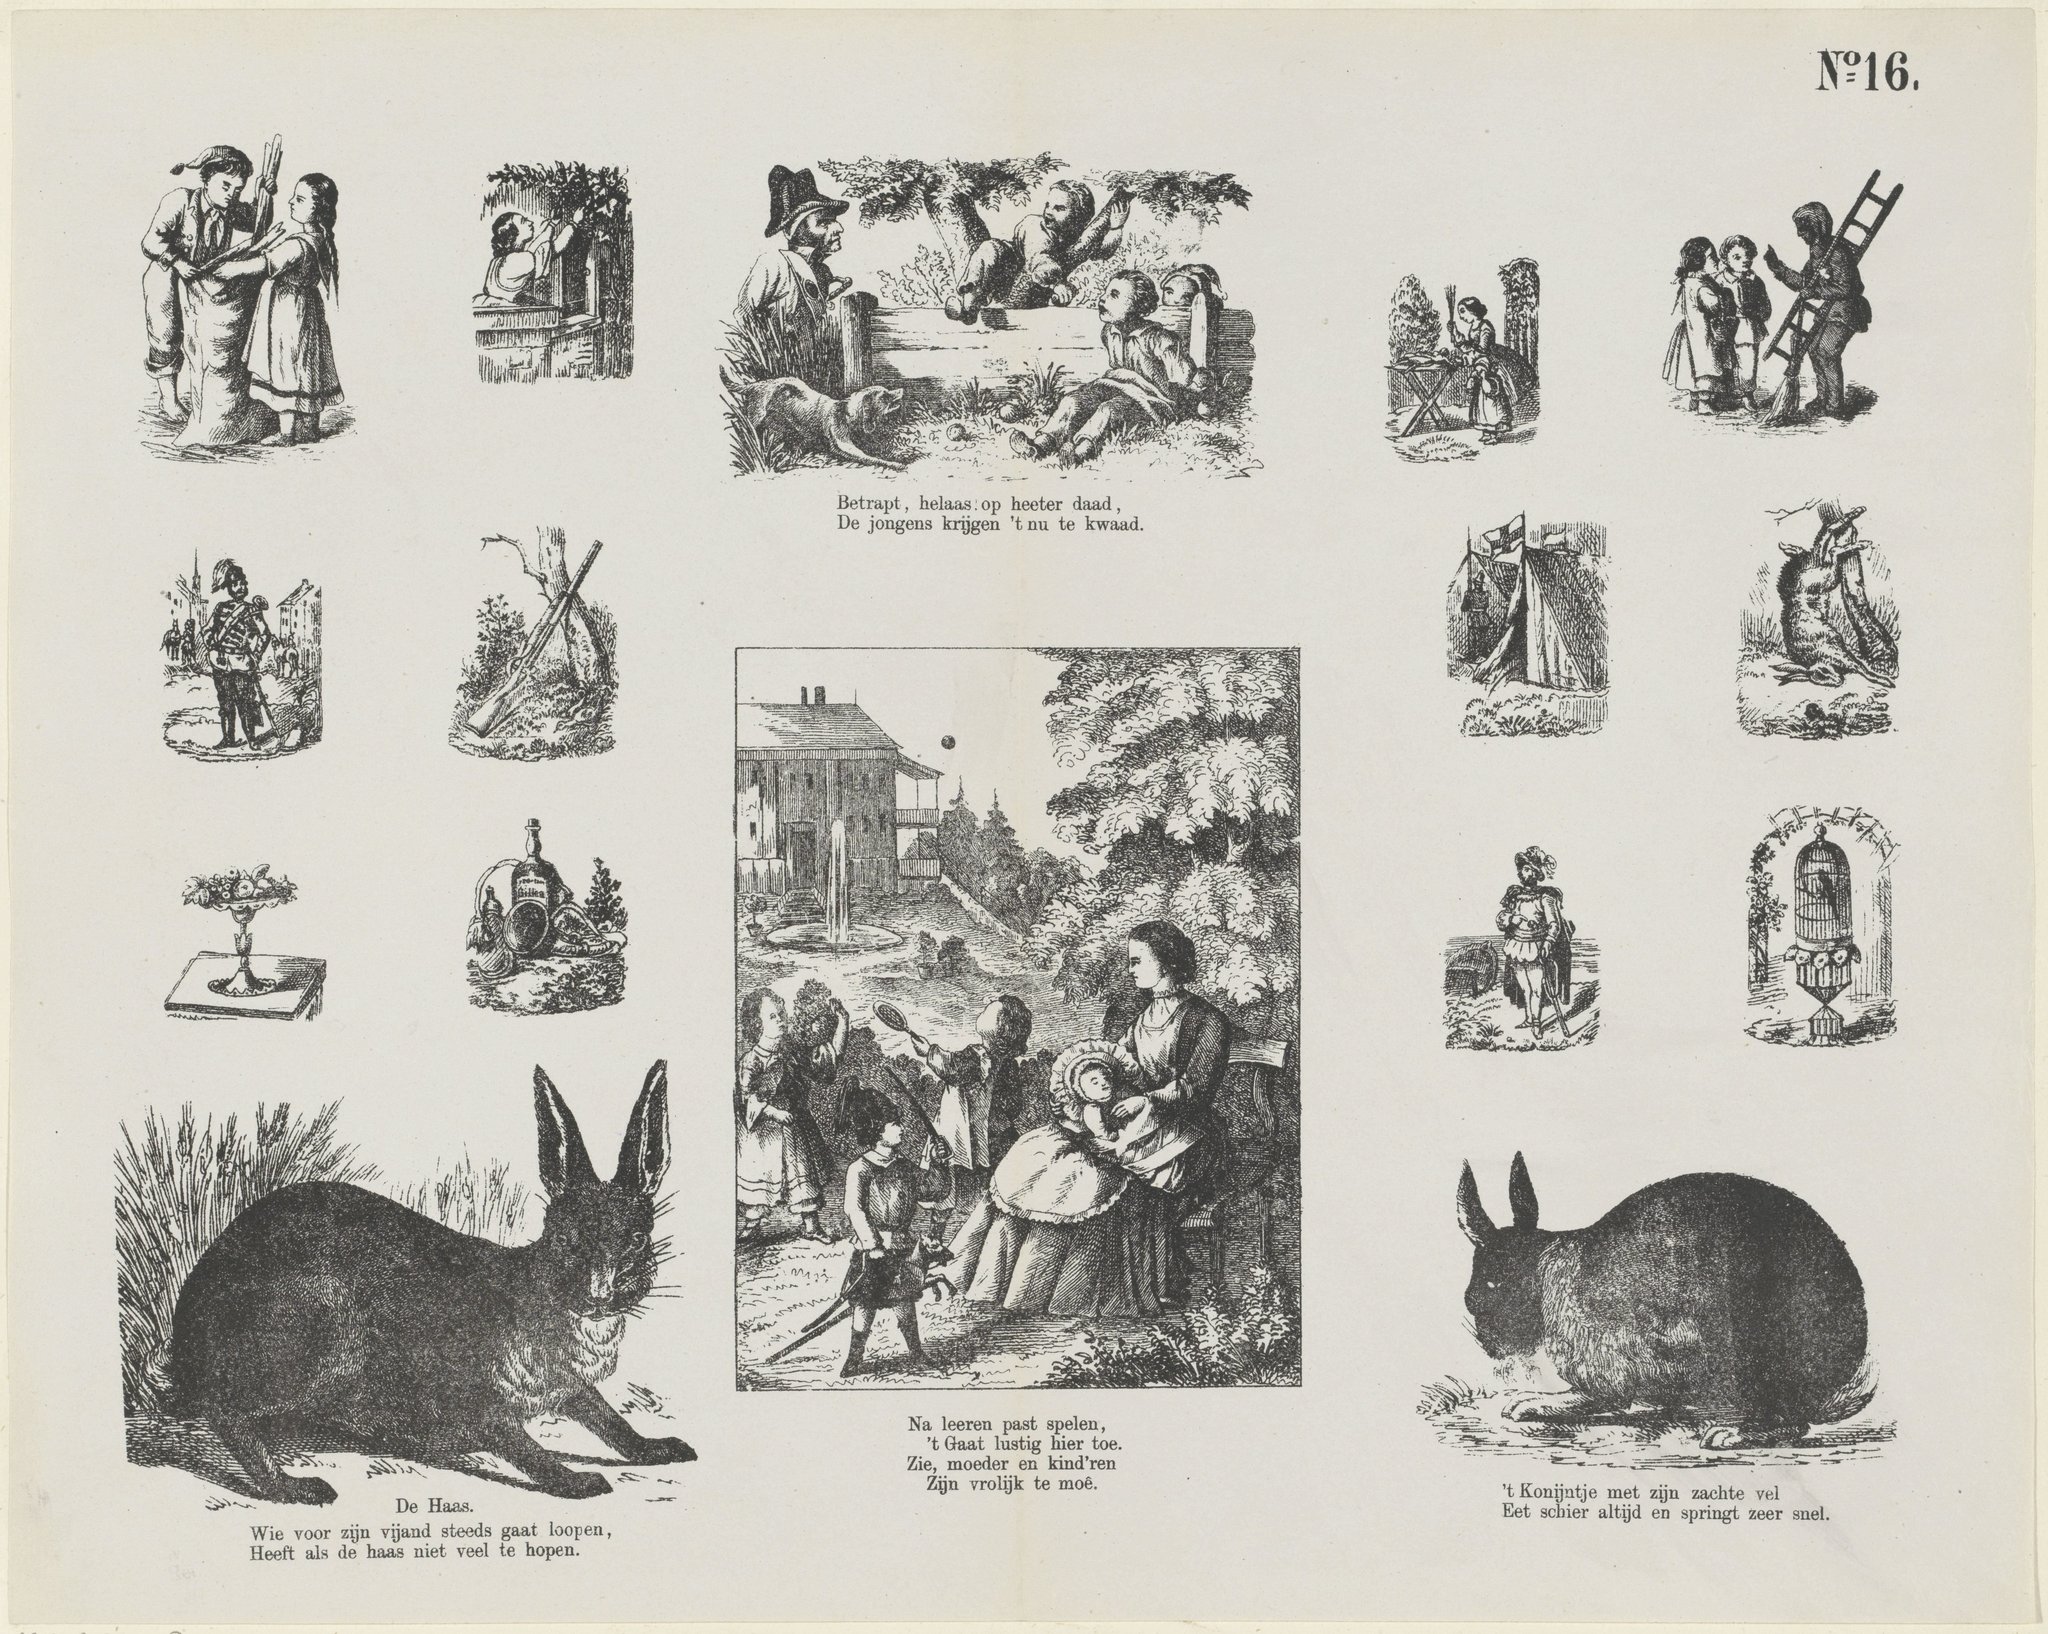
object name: popular print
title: Verschillende taferelen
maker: Anonymous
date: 1873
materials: paper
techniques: letterpress printing, lithograph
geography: amsterdam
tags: animals, birds, handicrafts ~ maintenance and repair (with name of trade or profession), the soldier; the soldier's life, fruits: cherry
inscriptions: collector's mark: Lugt 2760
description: Blad met 16 voorstellingen van verschillende aard, waaronder dieren, kinderen die hout sprokkelen, soldaten en een schoorsteenveger. Onder enkele afbeeldingen een onderschrift. Genummerd rechtsboven: No. 16.